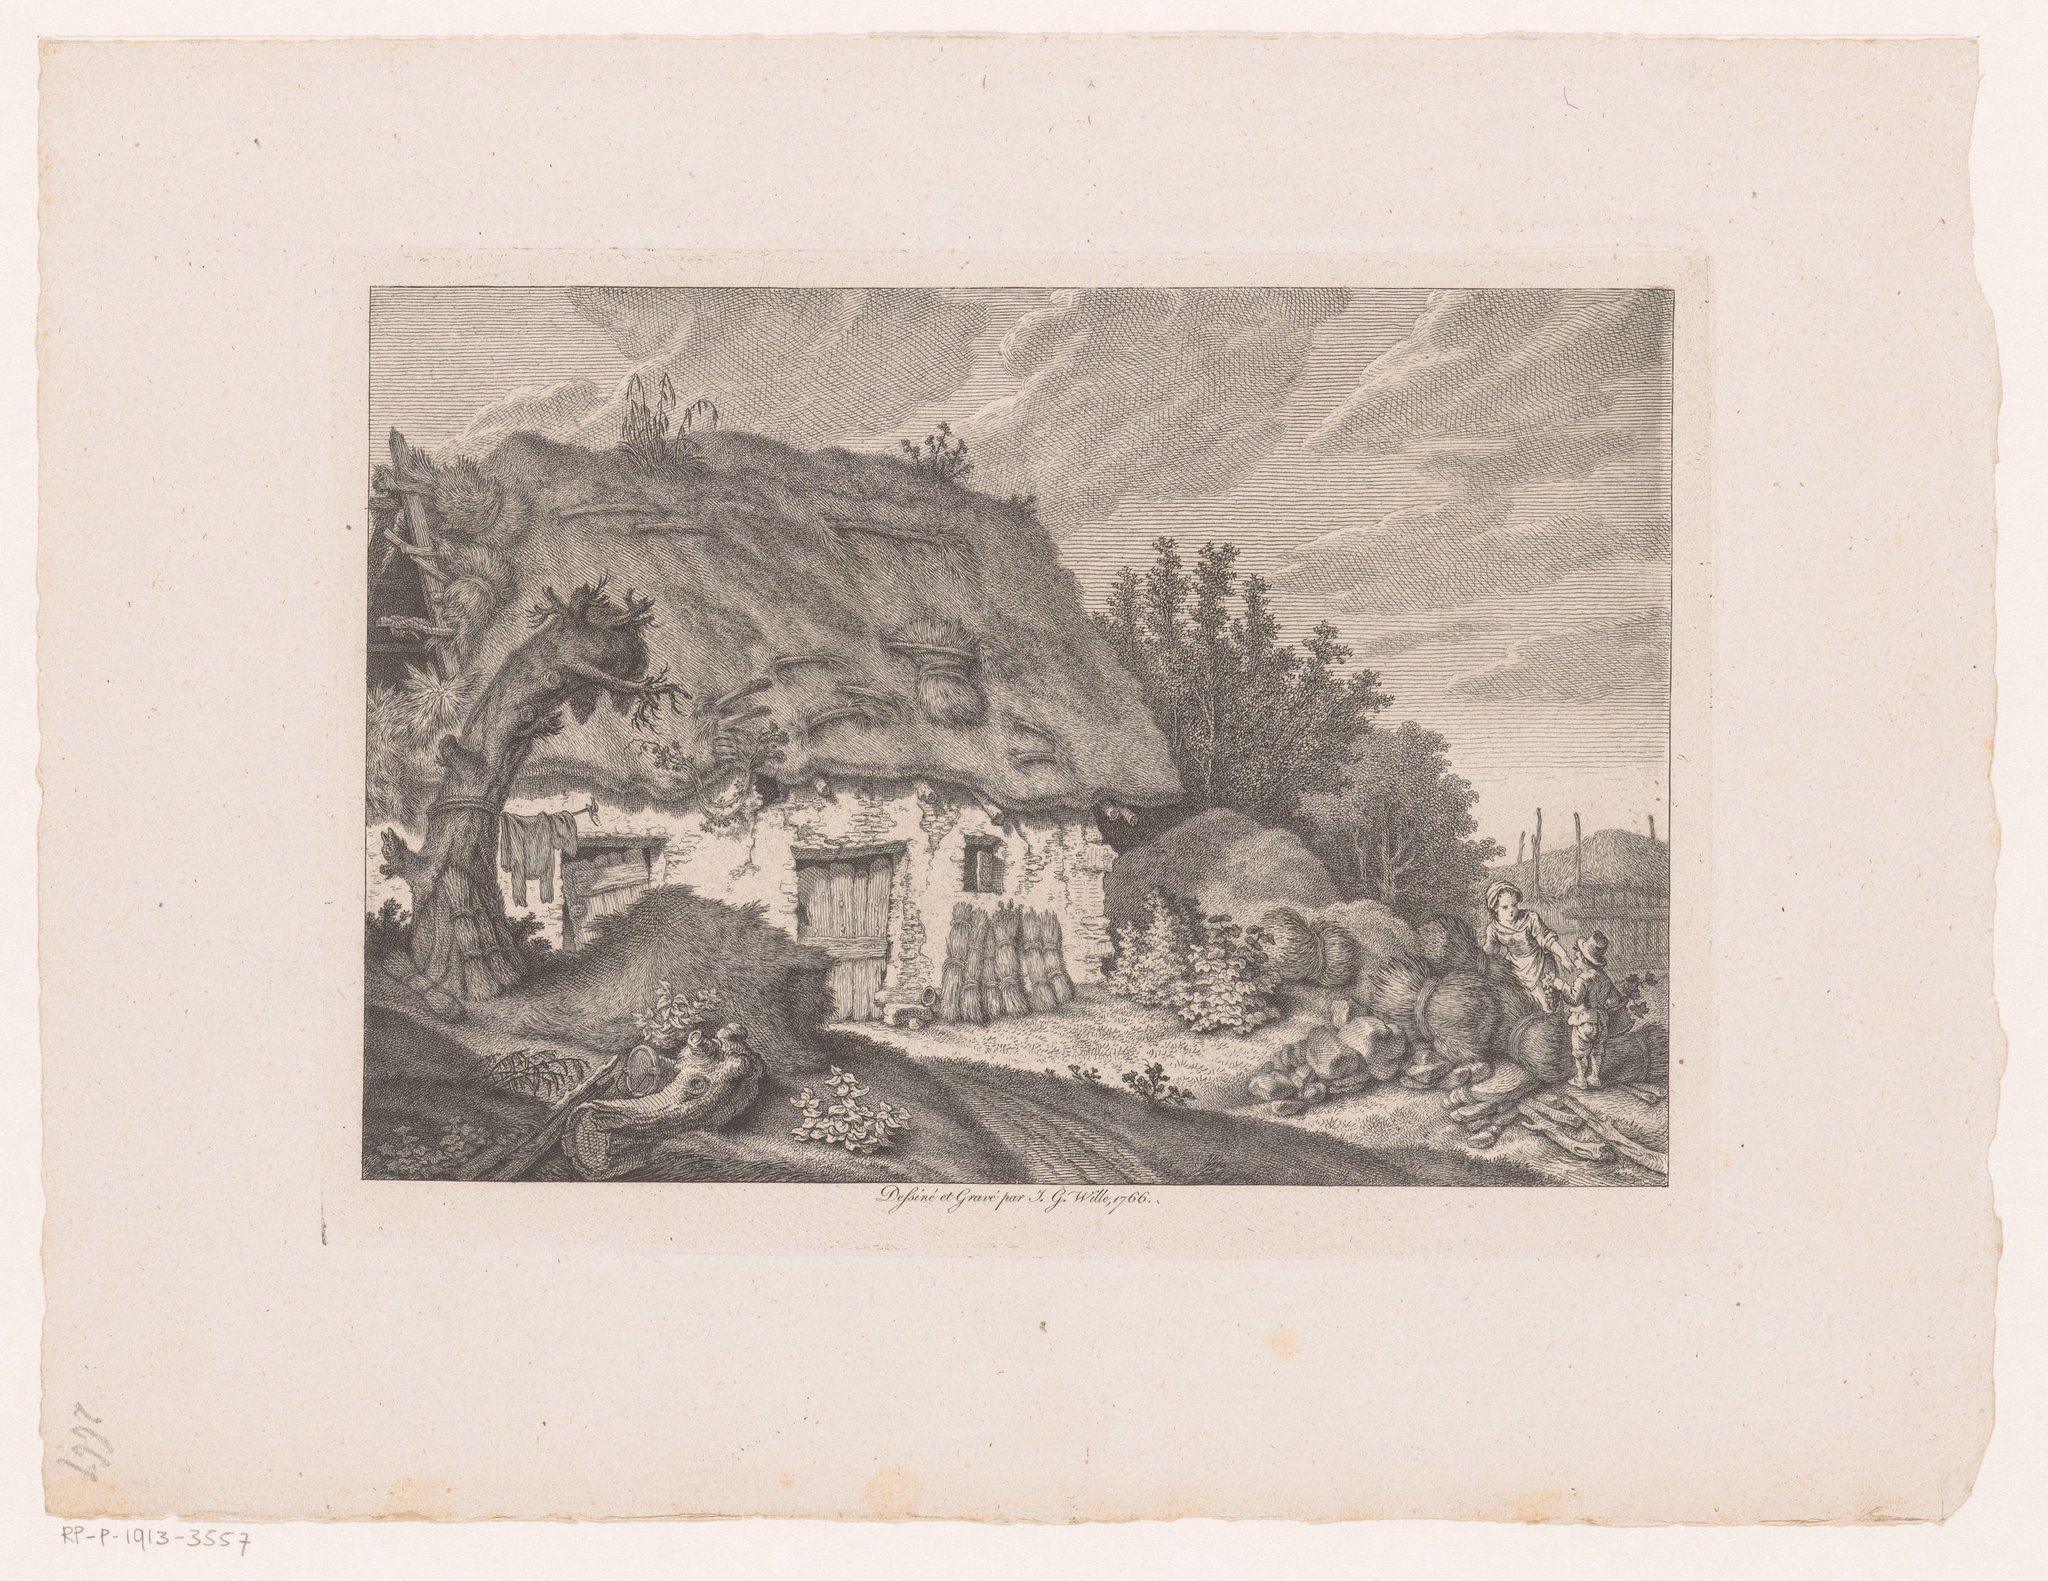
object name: print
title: Boerderij met hooibergen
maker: johann georg wille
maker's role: draughtsman, print maker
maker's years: 1715-1808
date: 1766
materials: paper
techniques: etching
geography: france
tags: city-view, and landscape with man-made constructions, hay-stack, farm (building), bunch of grapes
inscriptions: collector's mark